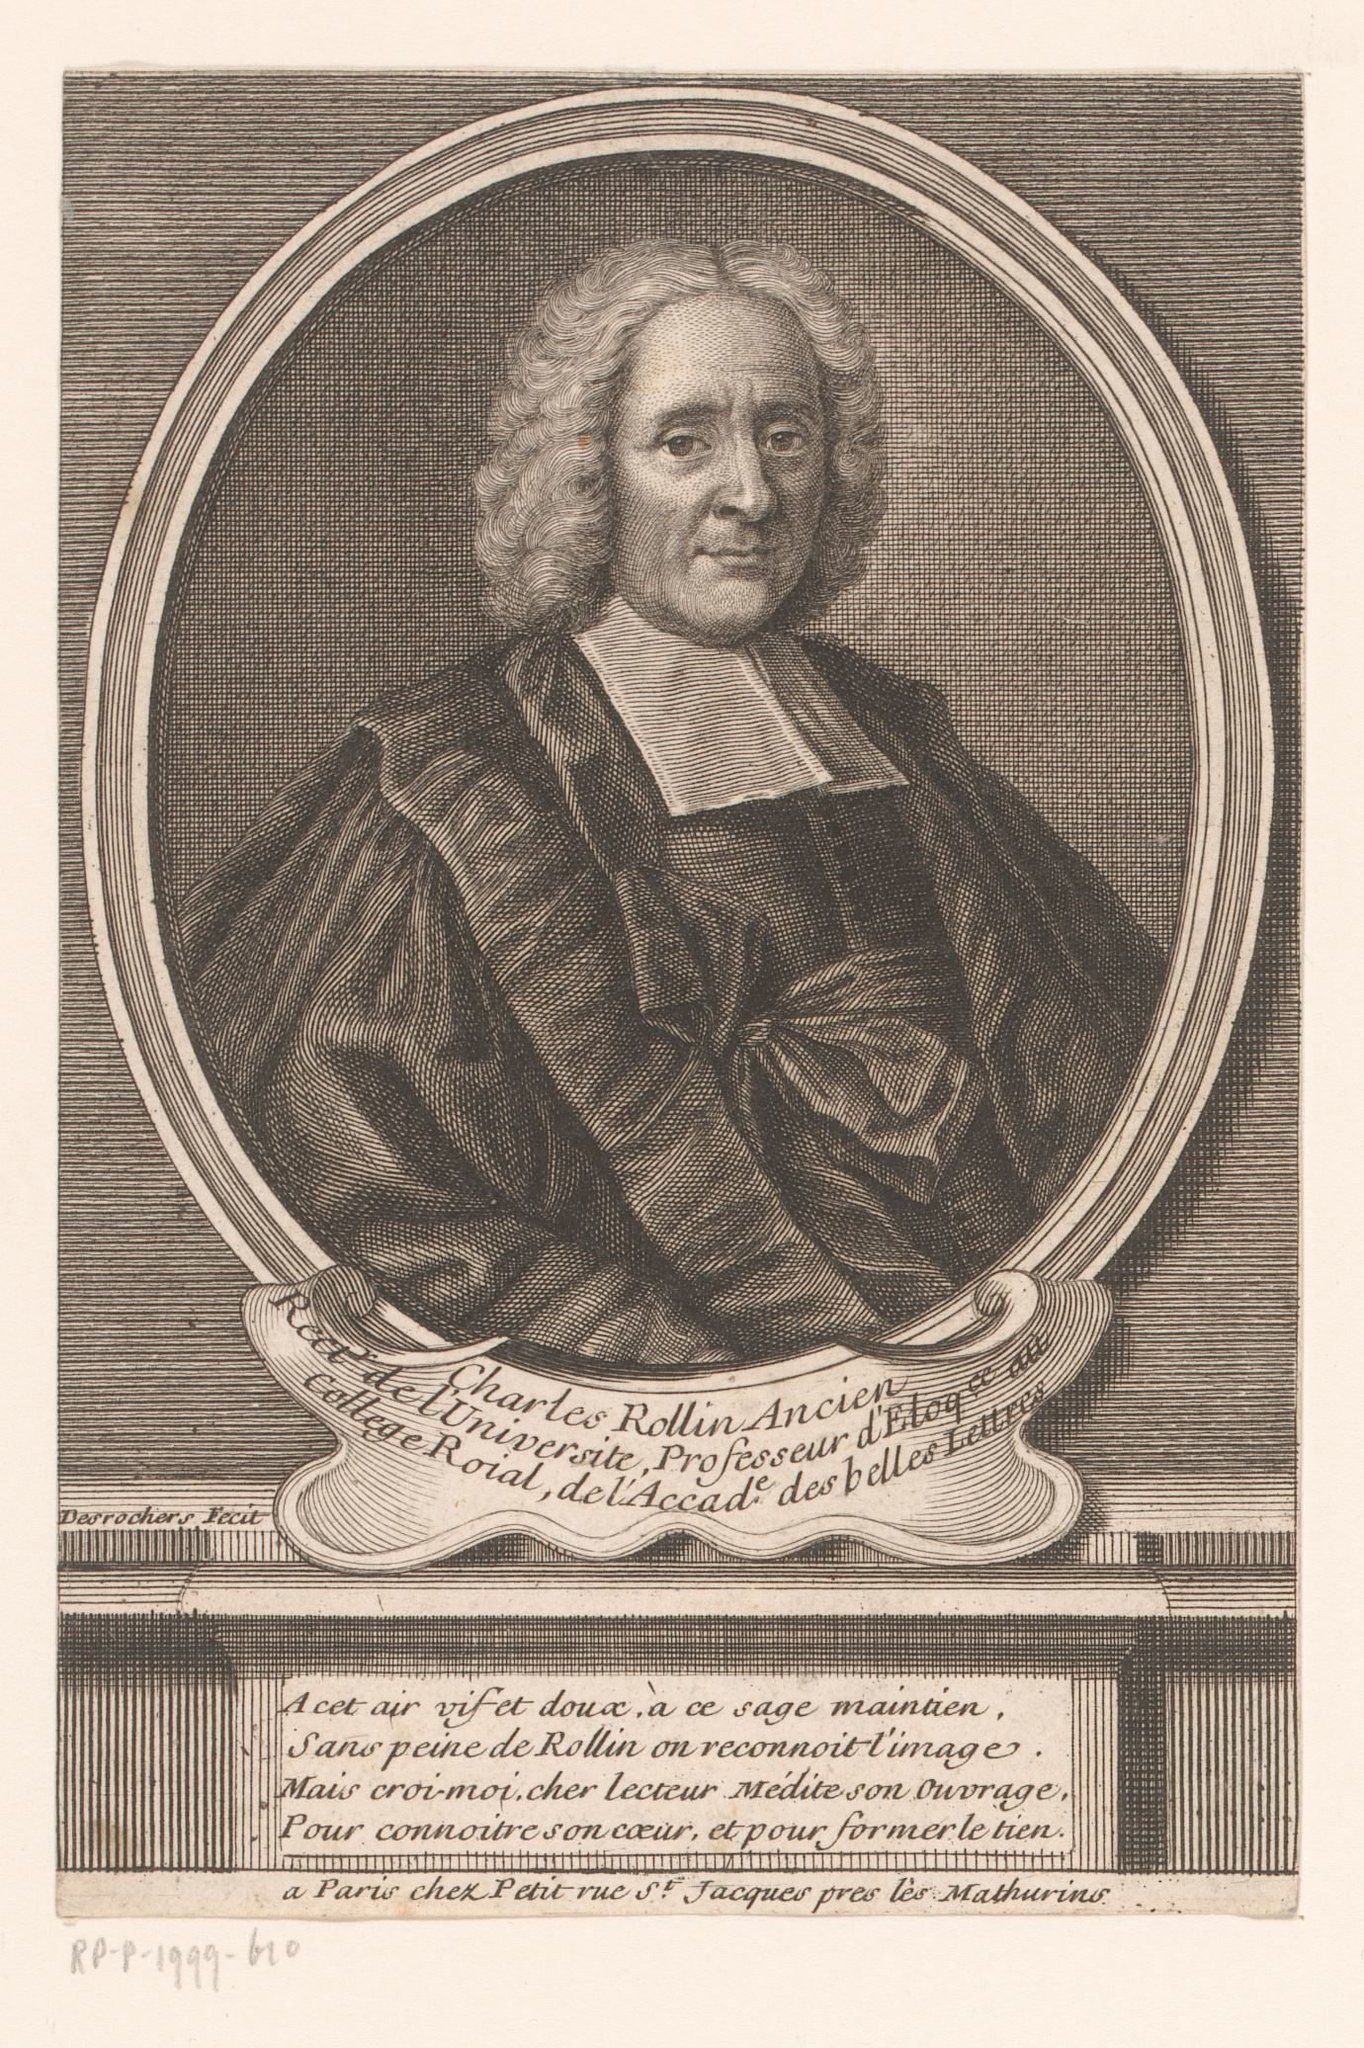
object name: print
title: Recueil de portraits (...)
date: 1726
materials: paper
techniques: engraving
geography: paris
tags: paris, charles rollin, theologian, historical persons, professor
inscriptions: collector's mark: Lugt 2228, collector's mark: Lugt 2760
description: Behoort waarschijnlijk tot een serie portretten, grotendeels door Etienne Desrochers, getiteld: 'Recueil de portraits de personnes qui se sont distinguées tant dans les Armes que dans Belles-Lettres et les Arts, comme aussi la famille royale de France et autres cours étrangères'. De serie werd initieel uitgegeven door Desrochers en aangekondigd in 'Mercure' in mei 1726, p. 985. Echter was Desrochers reeds enkele jaren eerder begonnen met het uitgeven van de serie. Na de dood van Desrochers werd de serie voortgezet door Gilles Edme Petit. Een latere staat werd uitgegeven door Jean François Daumont in Parijs.